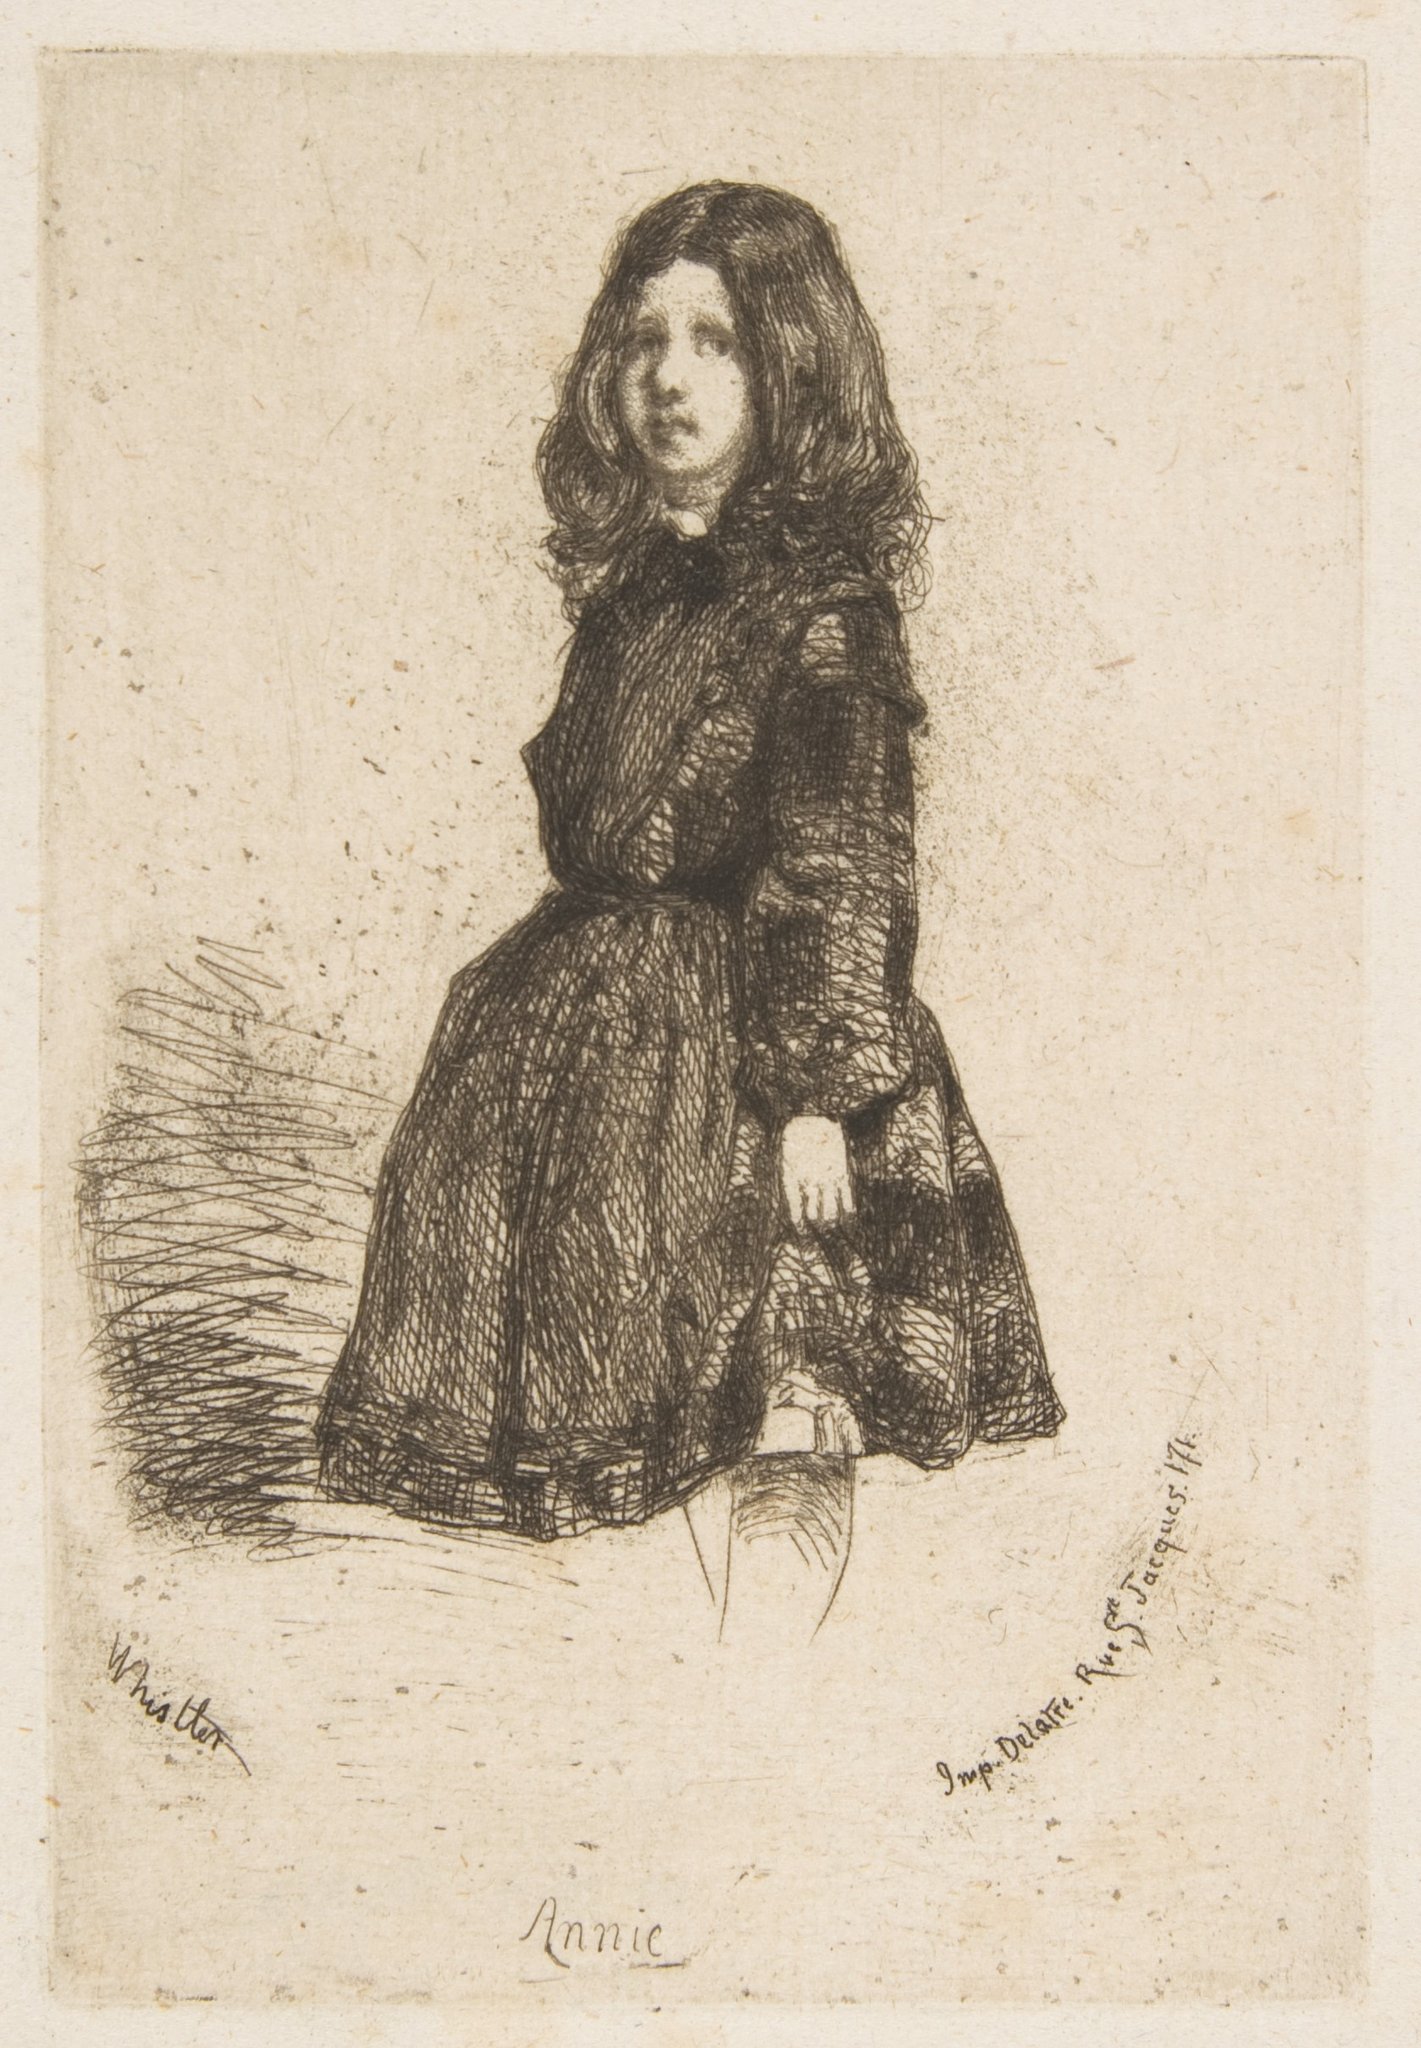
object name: print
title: Annie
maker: james mcneill whistler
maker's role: artist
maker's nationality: american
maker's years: 1834-1903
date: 1858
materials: ink, paper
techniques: etching, printing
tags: girls